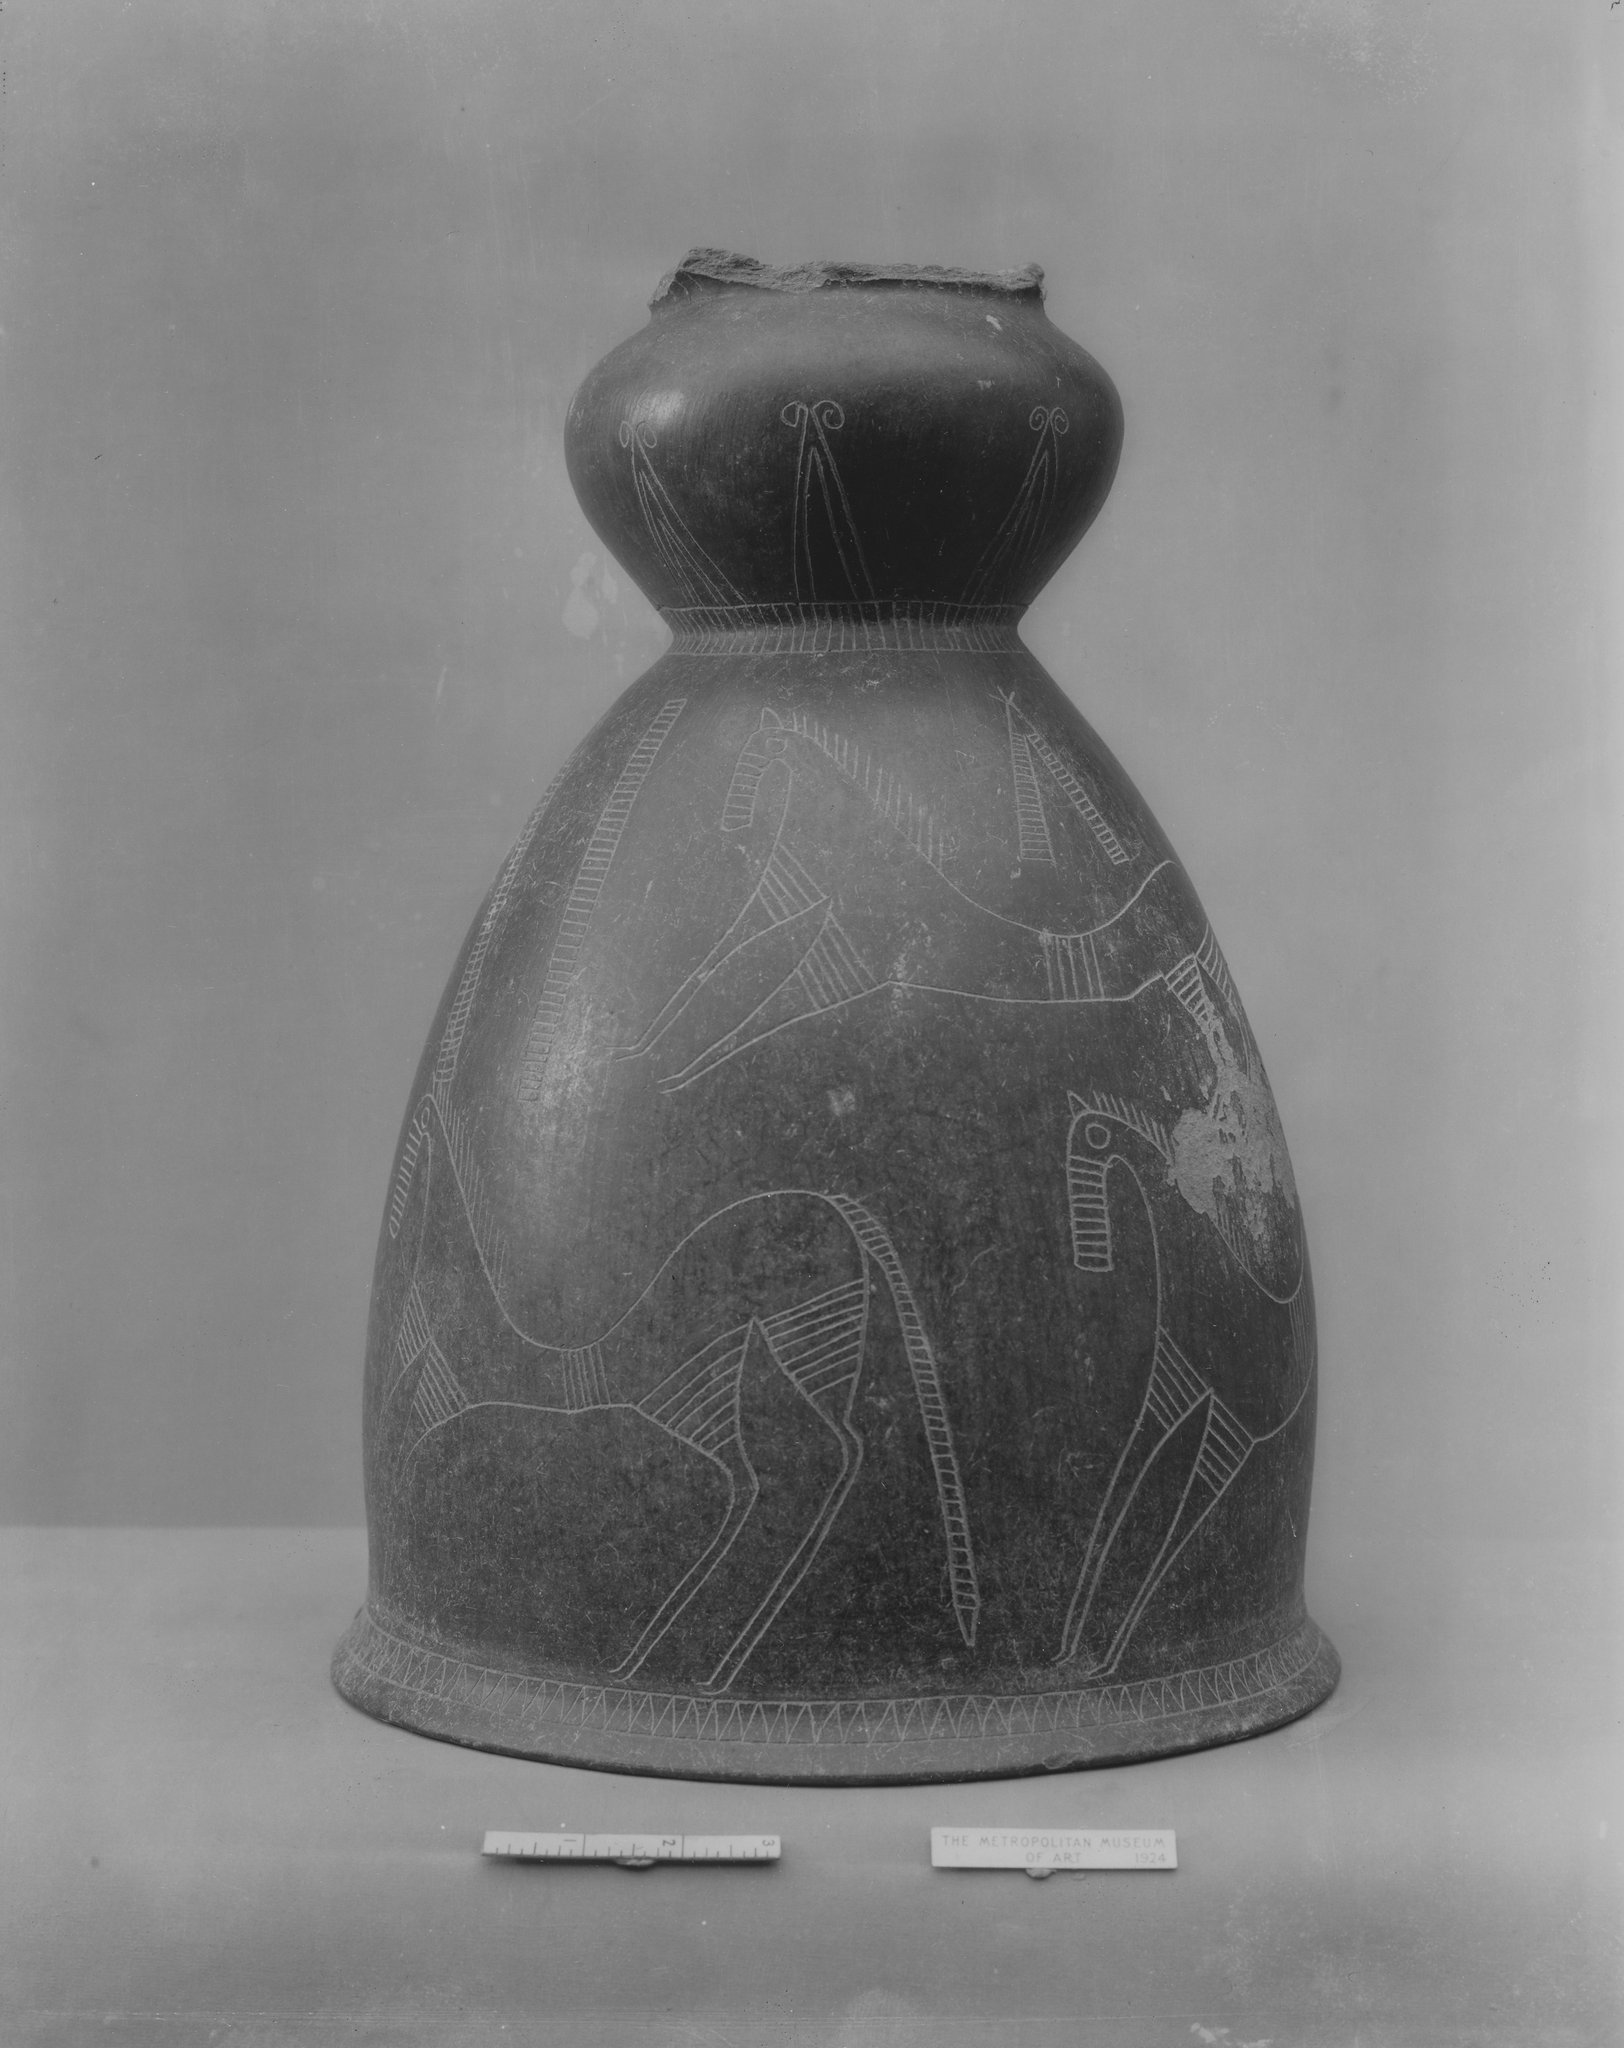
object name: stand for a cauldron, fragment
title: Terracotta stand for a cauldron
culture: italic, villanovan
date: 700-601 BCE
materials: terracotta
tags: horses